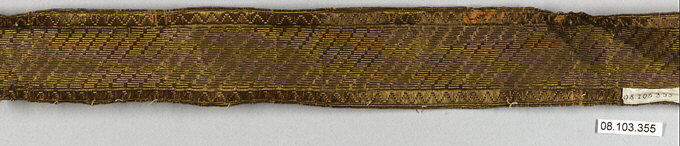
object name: galloon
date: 1601-1800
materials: metal thread